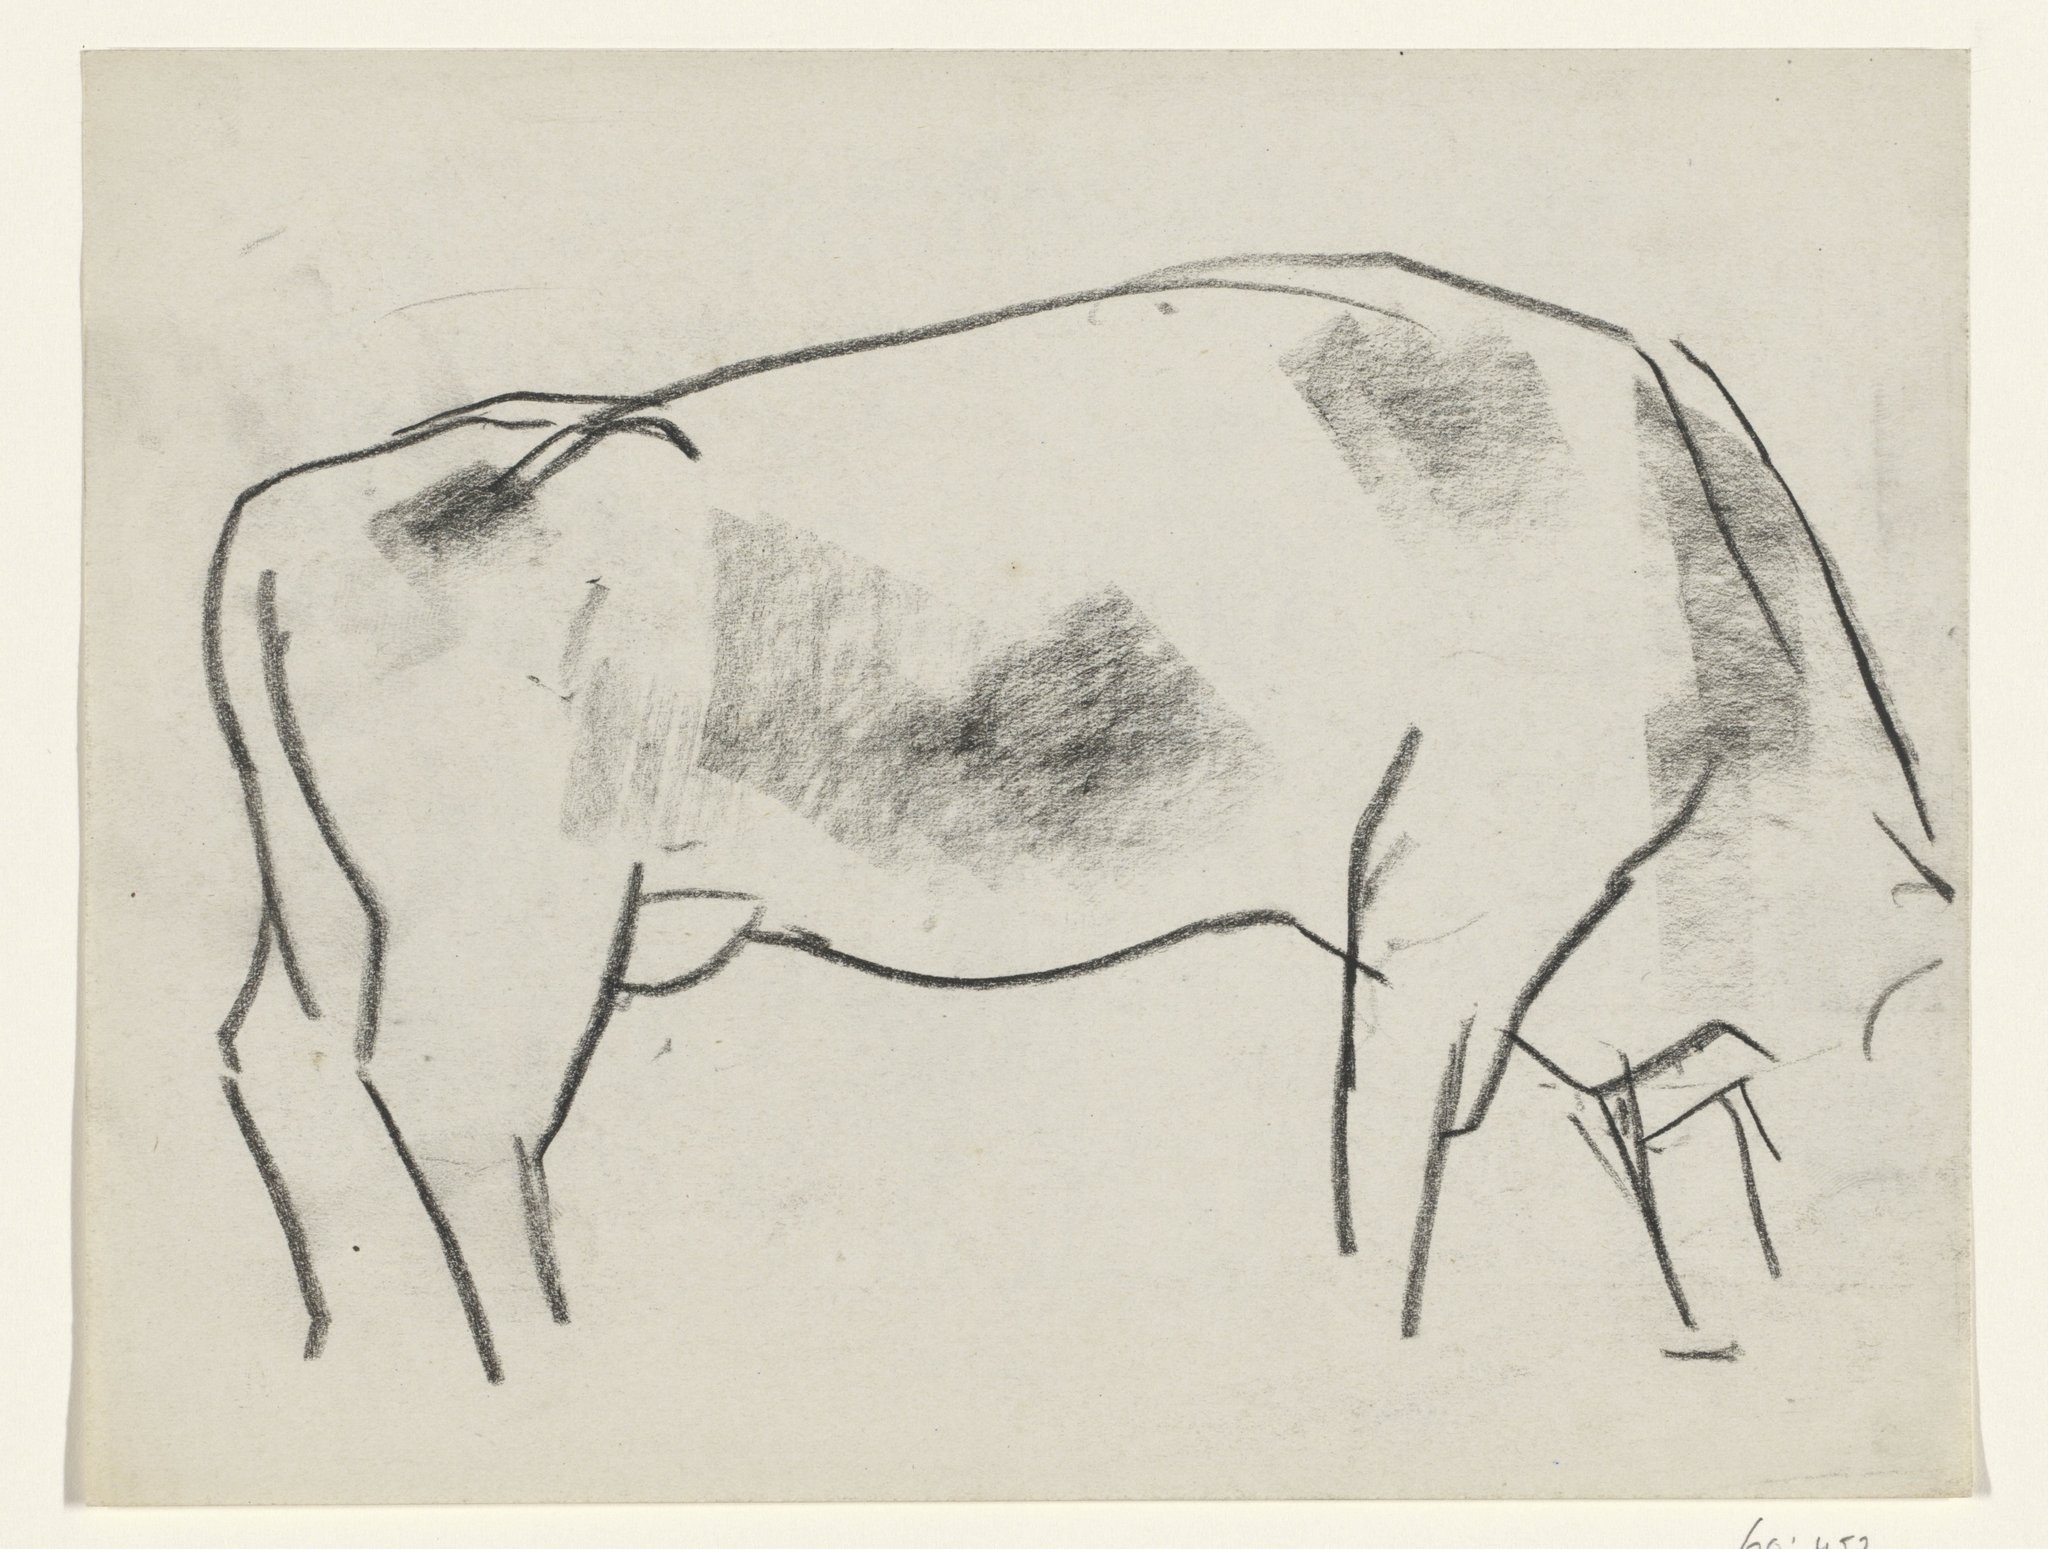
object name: drawing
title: Lichaam van een grazende koe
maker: leo gestel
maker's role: draughtsman, print maker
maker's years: 1881-1941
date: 1891-1941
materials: chalk, paper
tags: cow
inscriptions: collector's mark: Lugt 2228